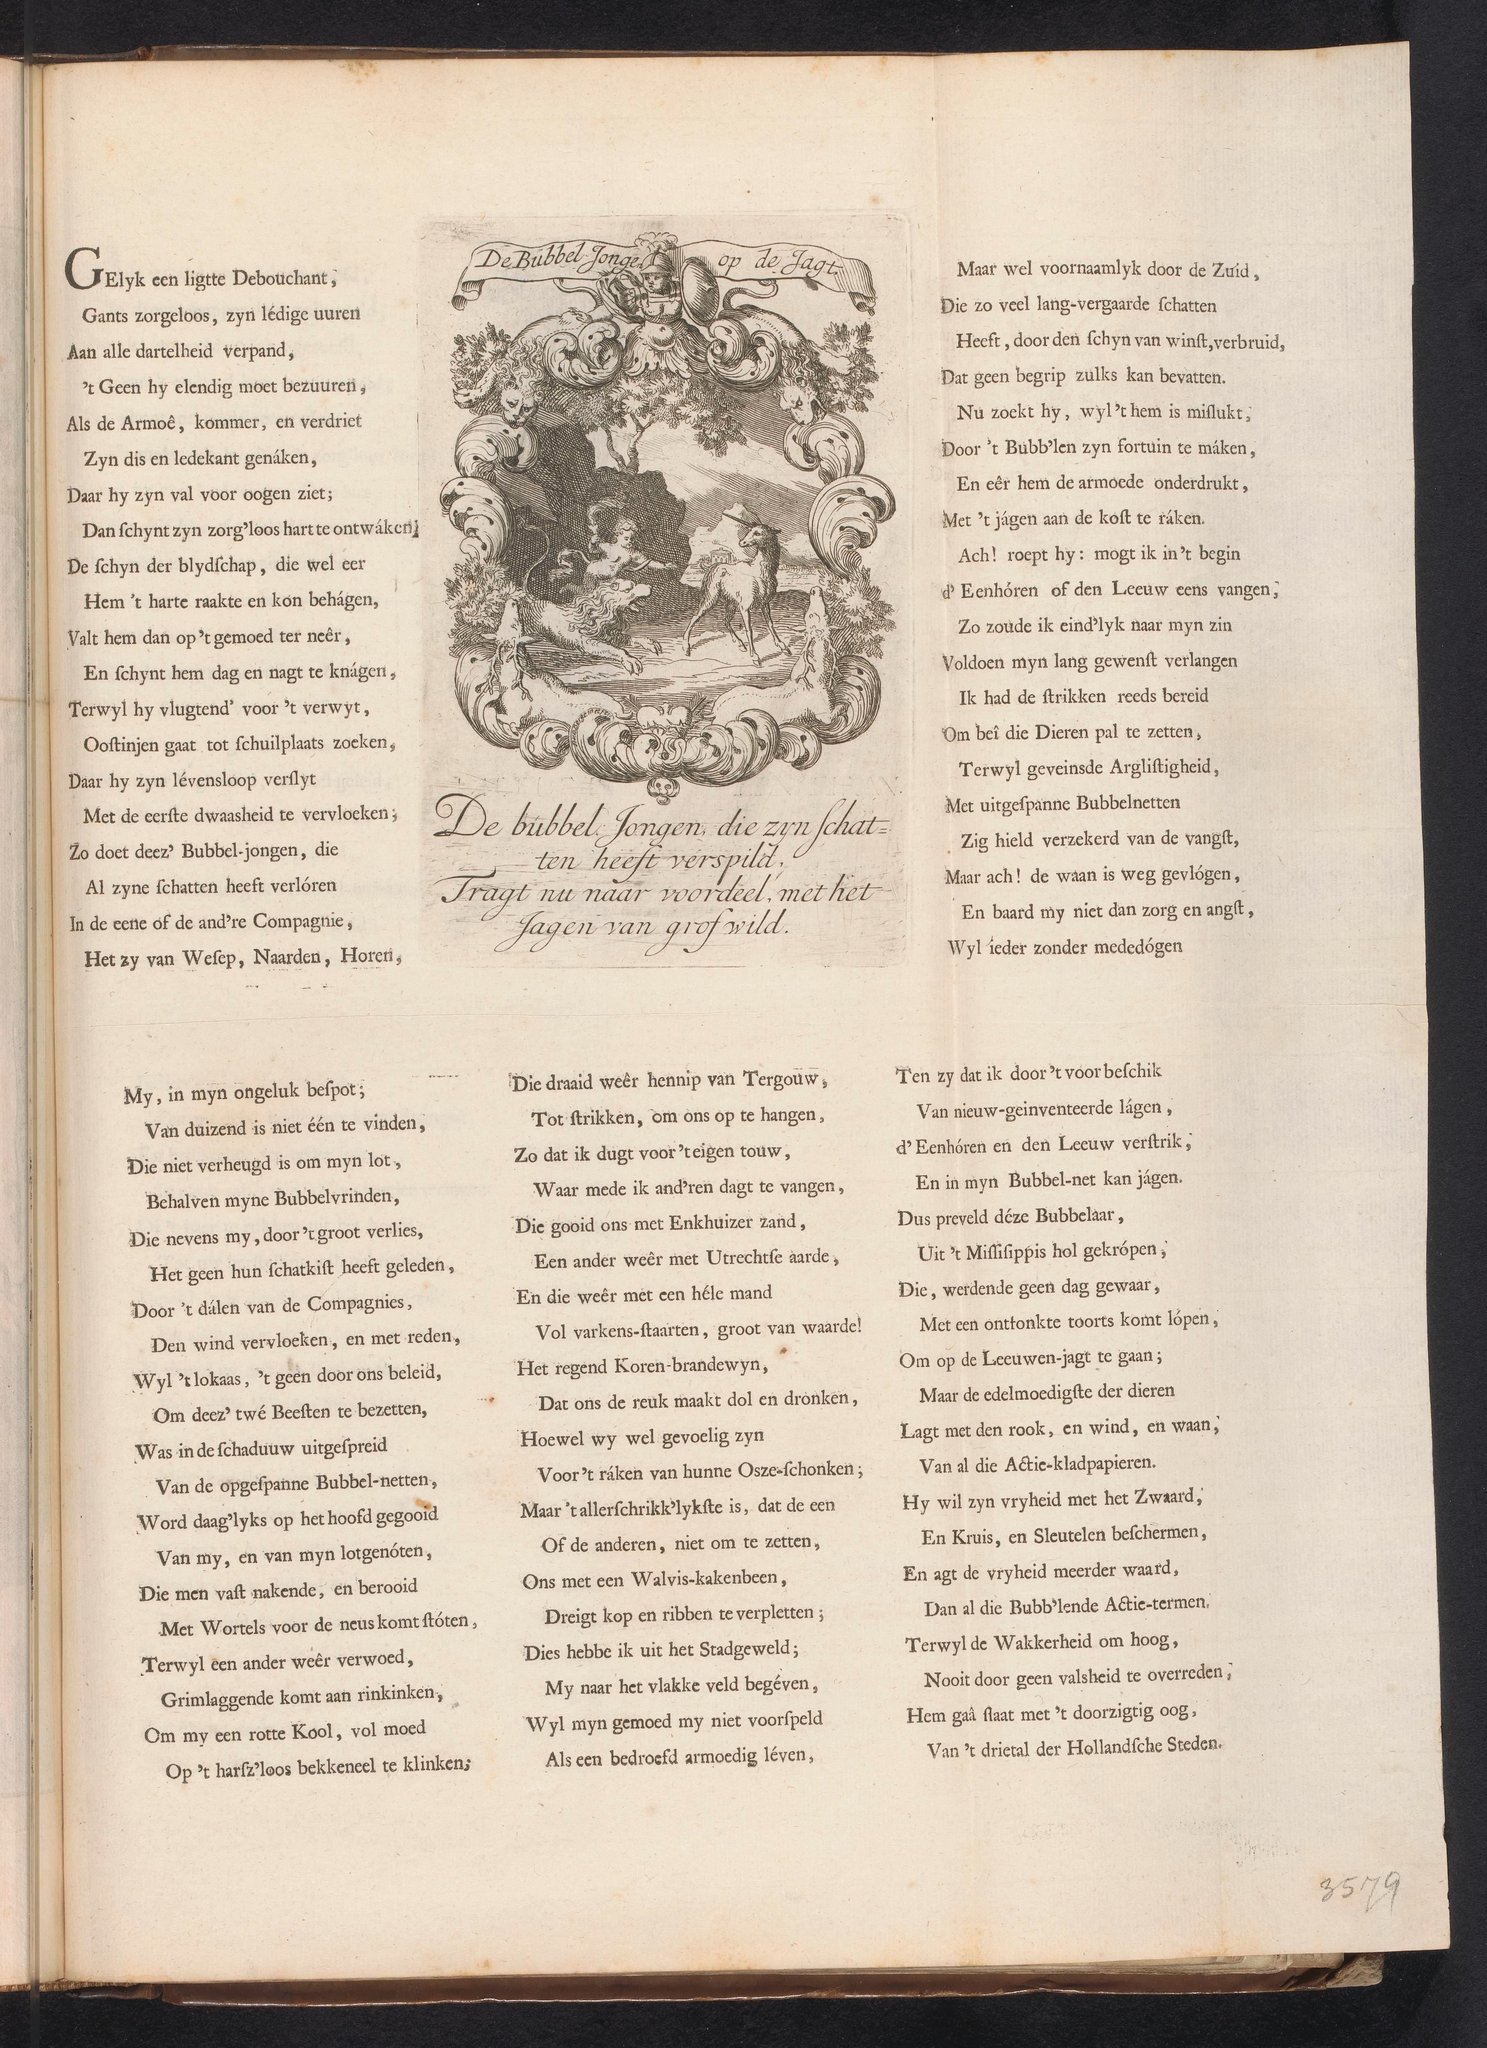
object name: cartoon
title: De Bubbel Jongen op de Jagt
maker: pieter van den berge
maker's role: draughtsman, print maker, printer, publisher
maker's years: 1659-1737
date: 1697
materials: paper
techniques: engraving, etching, letterpress printing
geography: northern netherlands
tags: unicorn, hunting, chase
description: De Bubbeljongen op jacht. Een door de windwandel berooide naakte jongen jaagt met een fakkel op een leeuw en eenhoorn. In een decoratieve omlijsting met leeuwen en herten. In het onderschrift een vers van vier regels. Gedrukt op het blad om en onder de plaat staan vijf verzen. Prent in de gebonden eerste uitgave (304 B 11) van Het Groote Tafereel der Dwaasheid met spotprenten op de Windhandel of Actiehandel van 1720.